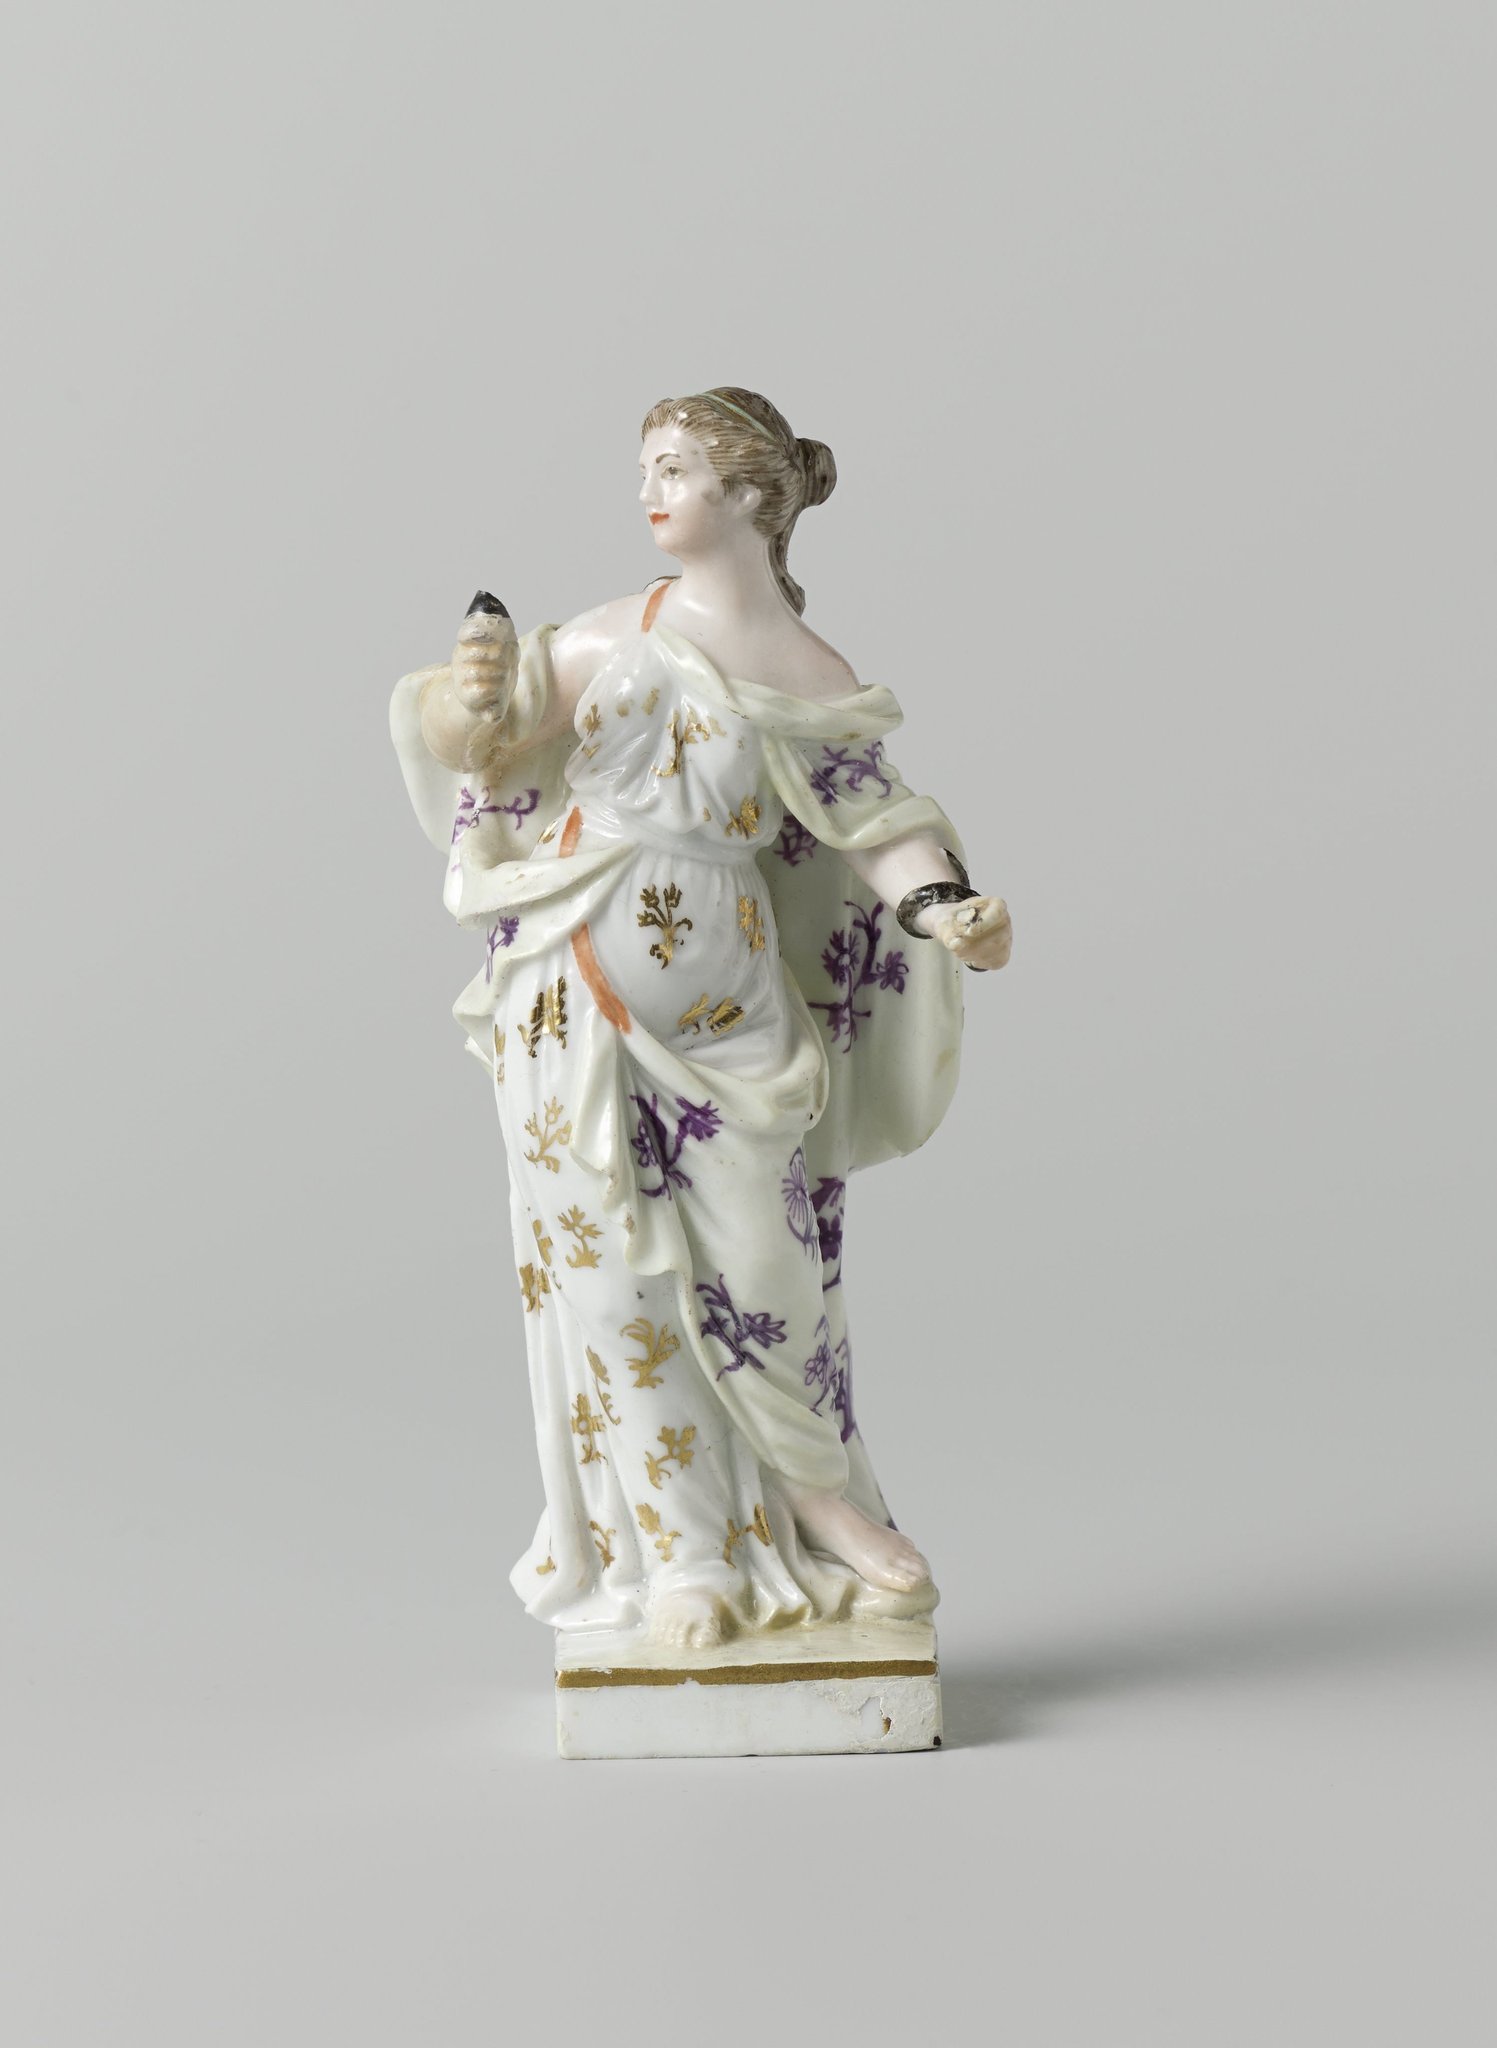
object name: figure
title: Prudentia (Voorzichtigheid)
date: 1779-1800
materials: porcelain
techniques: painted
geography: meissen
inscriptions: factory mark, model number: ‘1457’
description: Figuur van beschilderd porselein. Op een vierkant goud gerand voetstuk staat een vrouw (Prudentia) met in haar rechter opgeheven hand een zwarte spiegel en in haar linkerhand een zwarte slang. De figuur is gemerkt.